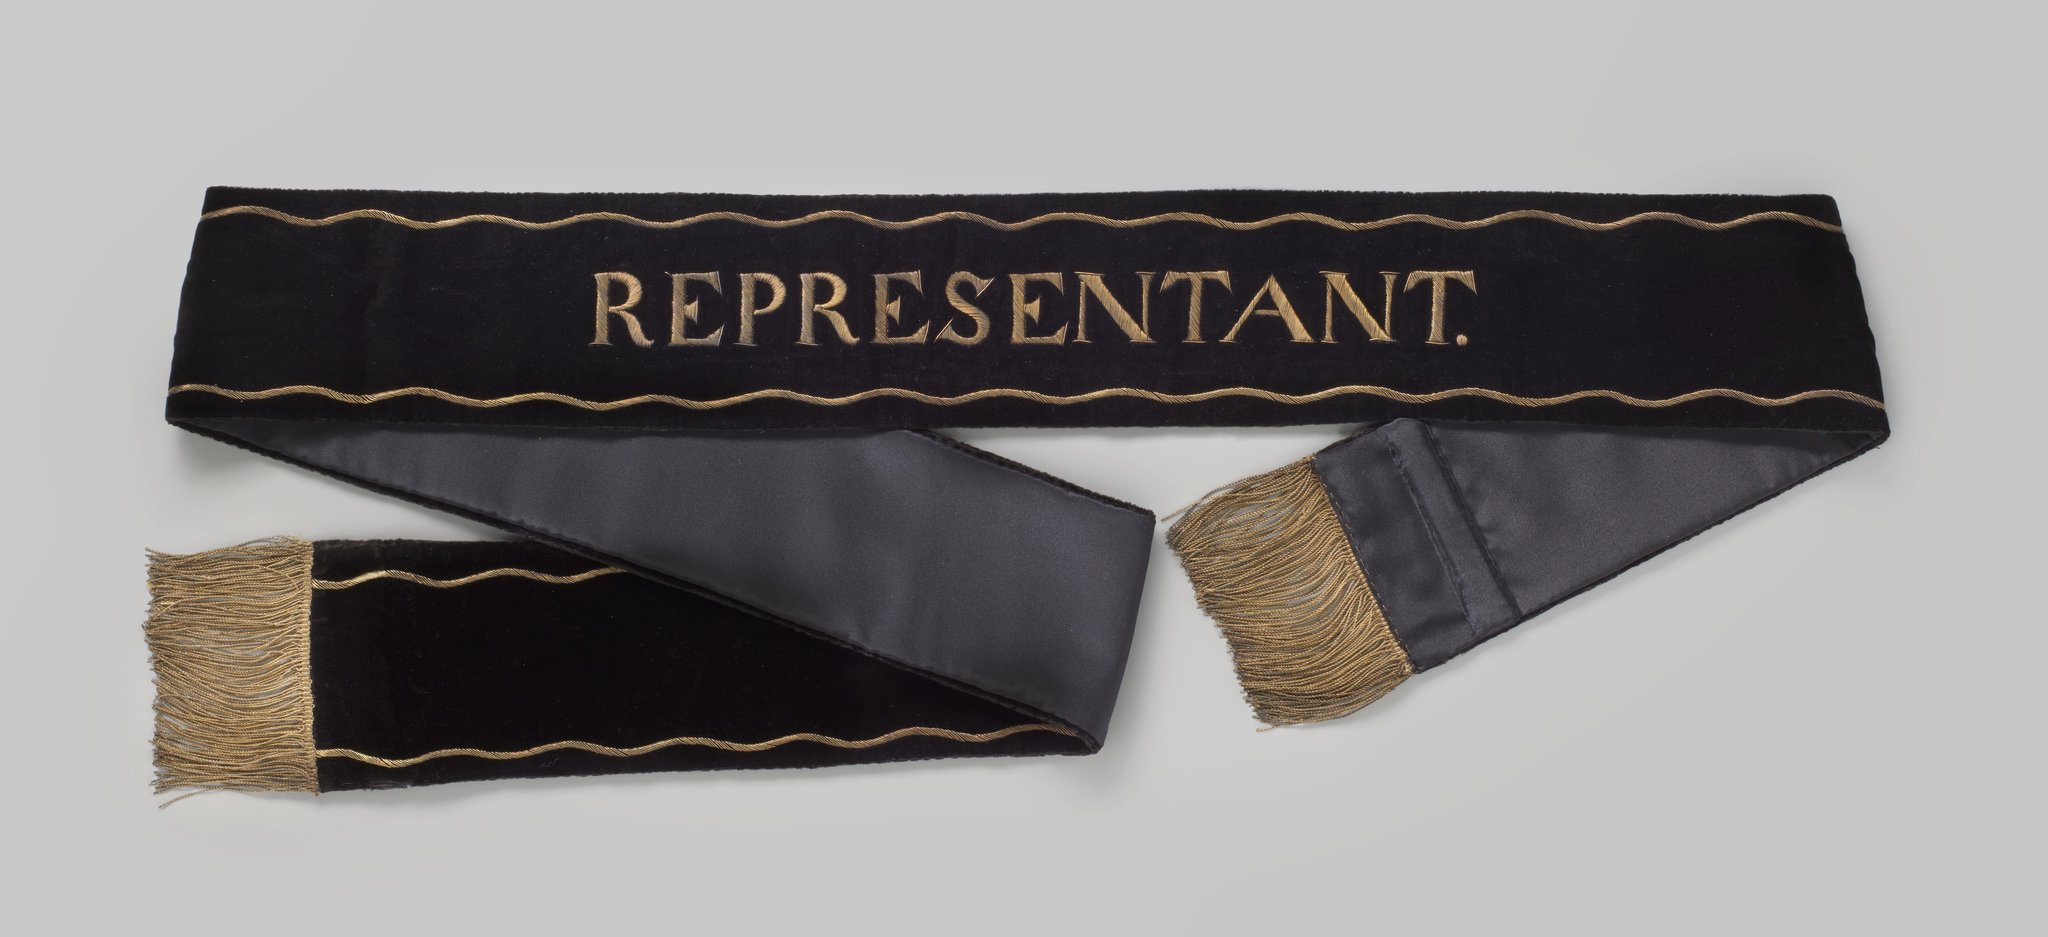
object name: clothing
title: Draaglint Representant Willem Gerard van der Grijp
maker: Anonymous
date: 1796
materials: textile, linen, thread, velvet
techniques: embroidered, gilding, weave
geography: netherlands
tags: noordgouwe, willem gerard van der grijp, nationale vergadering, goes, eerste nationale vergadering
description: Zwart velours of fluwelen lint met franjes van verguld zilver aan beide uiteinden. Met verguld zilverdraad is op het lint REPRESENTANT geborduurd, met over de hele lengte van het lint boven en onderlangs een golvende lijn. Het lint is gemonteerd op linnen en heeft een voering van molton. Het lint wordt aan de uiteinden verzwaard door langwerpige loodjes die in de voering zijn bevestigd. Het draaglint werd door Willem Gerard van der Grijp gedragen als representant van het district Goes in de eerste Nationale Vergadering in 1796.